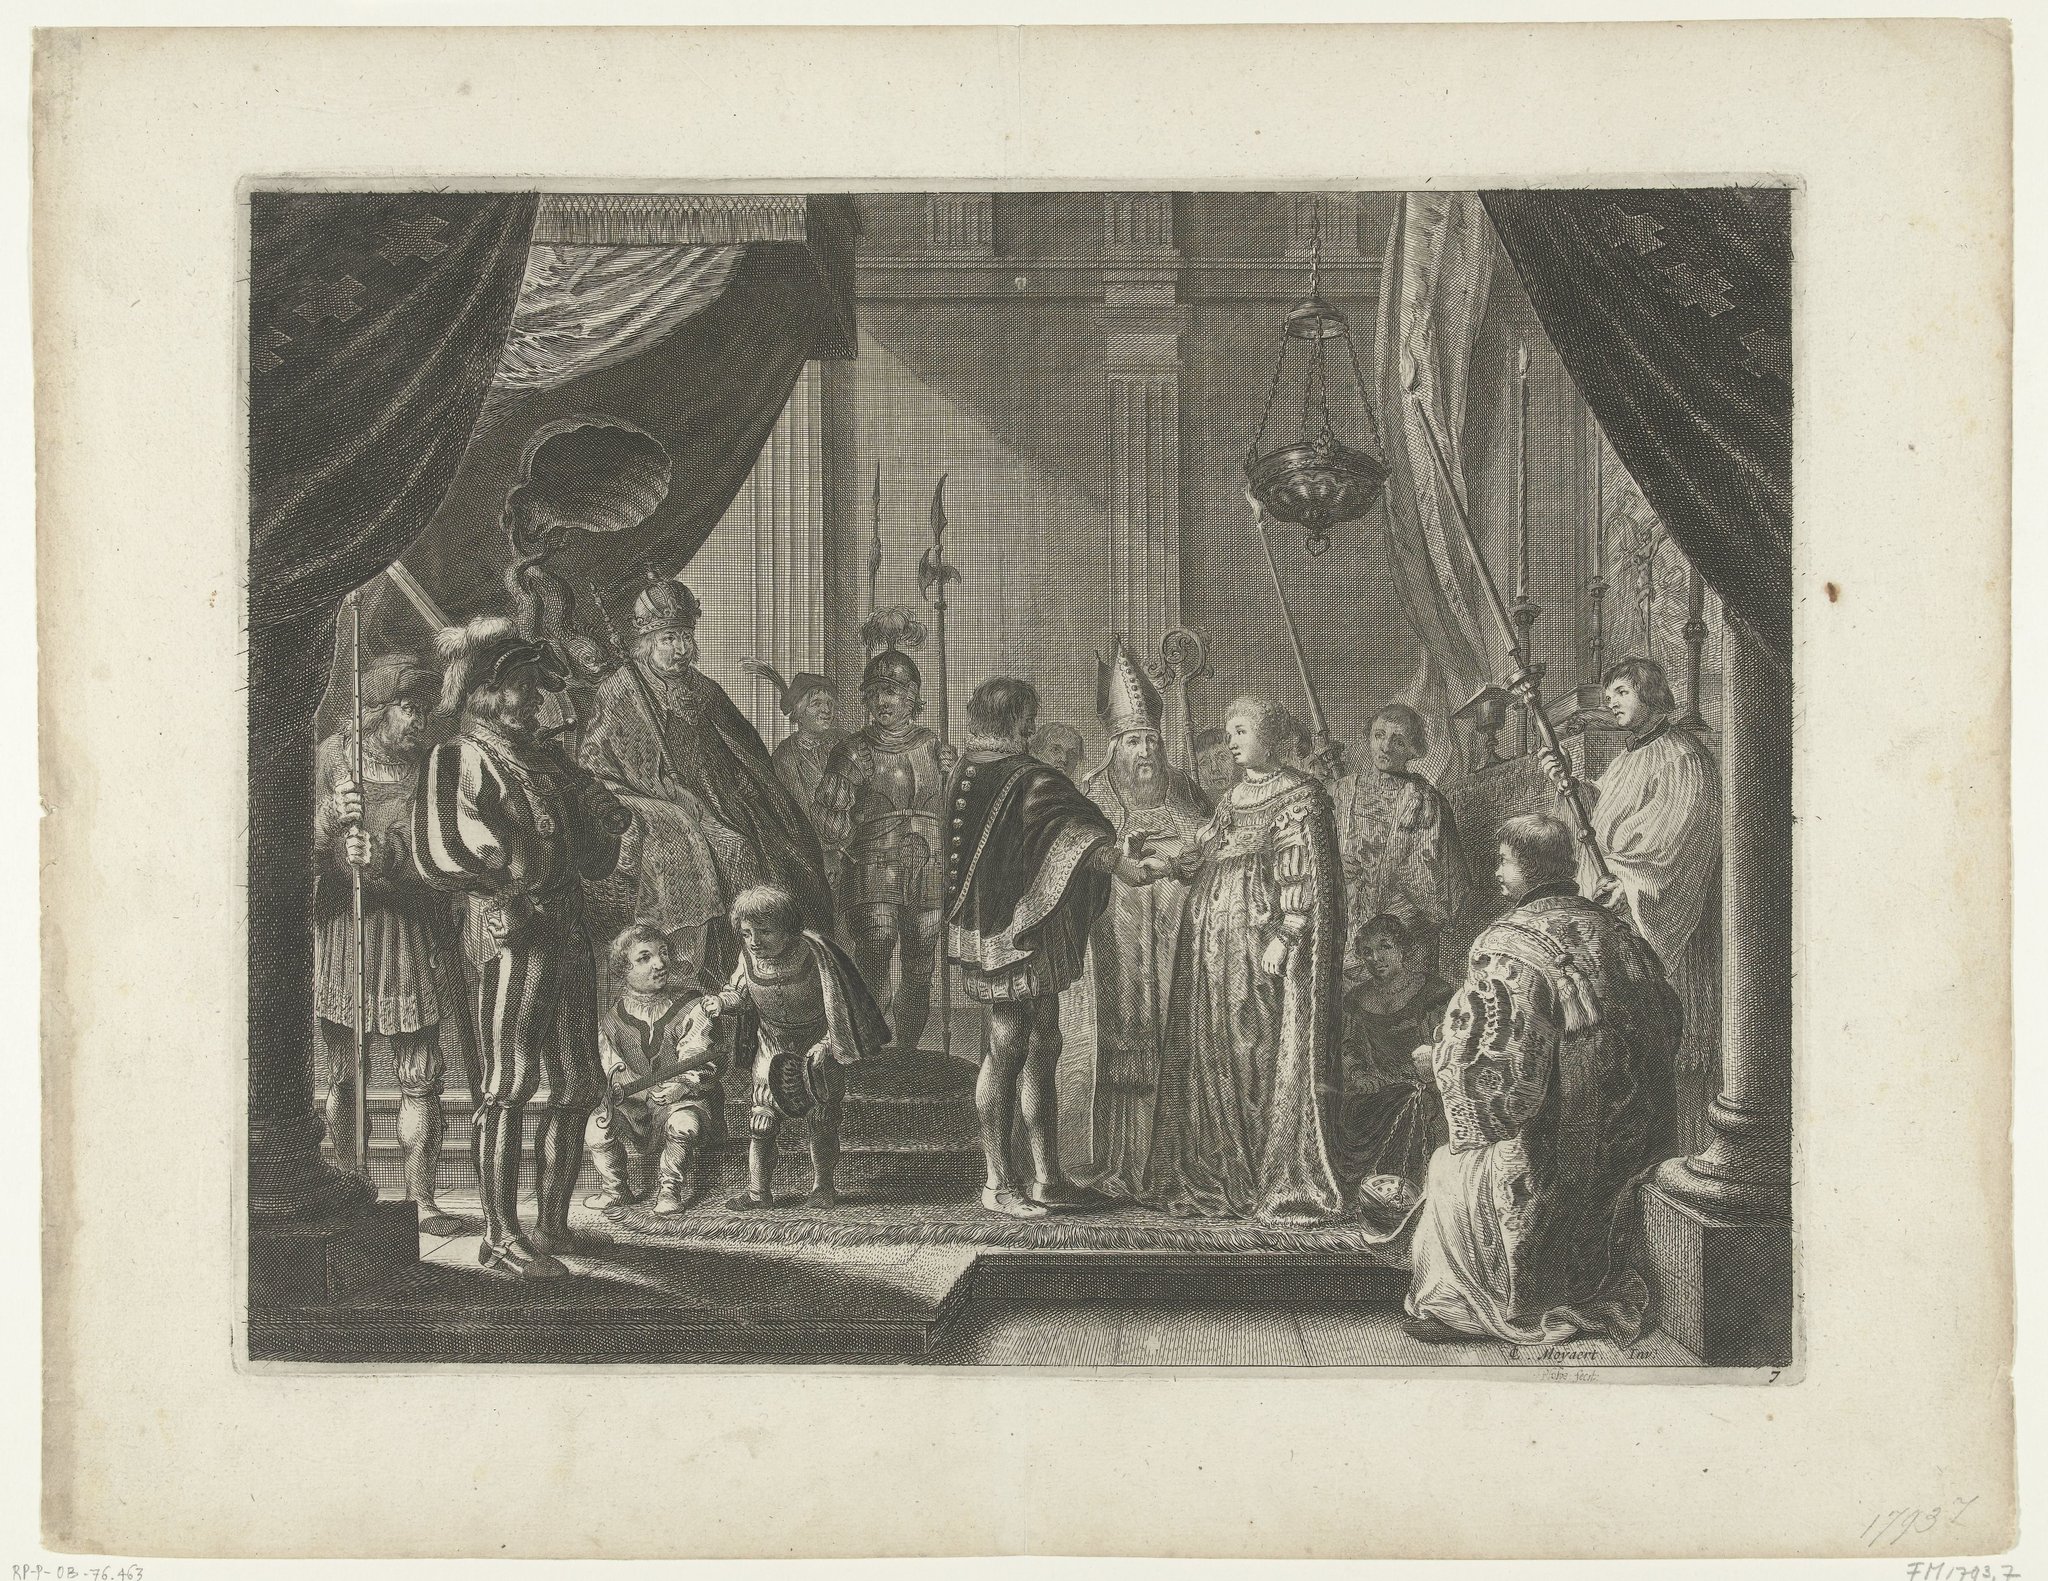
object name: print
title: Feestelijkheden bij het bezoek van Maria de' Medici aan Amsterdam in 1638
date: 1638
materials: paper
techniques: engraving, etching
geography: amsterdam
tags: prague, francesco i de' medici, cologne, maria de' medici, ferdinand i van habsburg (duits keizer), 'tableau vivant', triumphal entry and public reception, pageant, 'entrée solennelle', 'joyeuse entrée', blessing the married couple, (civil) marriage ceremonies, amsterdam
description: Prent ook gebruikt in:* Baerle, Caspar van. Medicea hospes, sive descriptio publicae gratulationis, qua Serenissimam, Augustissimamque Reginam, Mariam de Medicis (…). Amsterdam: Johannes en Cornelis Willemsz. Blaeu, 1638. En in: Baerle, Caspar van. Marie de Medicis, entrant dans Amsterdam : ou, histoire de la reception faicte à la Reyne Mere du Roy tres-Chrestien (…). Amsterdam: Johannes en Cornelis Willemsz. Blaeu, 1638. En in: Baerle, Caspar van en Joost van den Vondel. Blyde inkomst der allerdoorluchtighste koninginne, Maria de Medicis t' Amsterdam. Vertaelt uit het Latijn (…). Amsterdam: Johannes en Cornelis Willemsz. Blaeu, 1639. * Doorgaans zijn de prenten in de bovengenoemde publicaties rechtsonder genummerd (van de huidige prent is dat de derde bekende staat). Maar er zijn ook exemplaren waarin eerdere, ongenummerde, staten van de prenten (van de huidige prent de eerste en tweede bekende staat) zijn ingebonden.